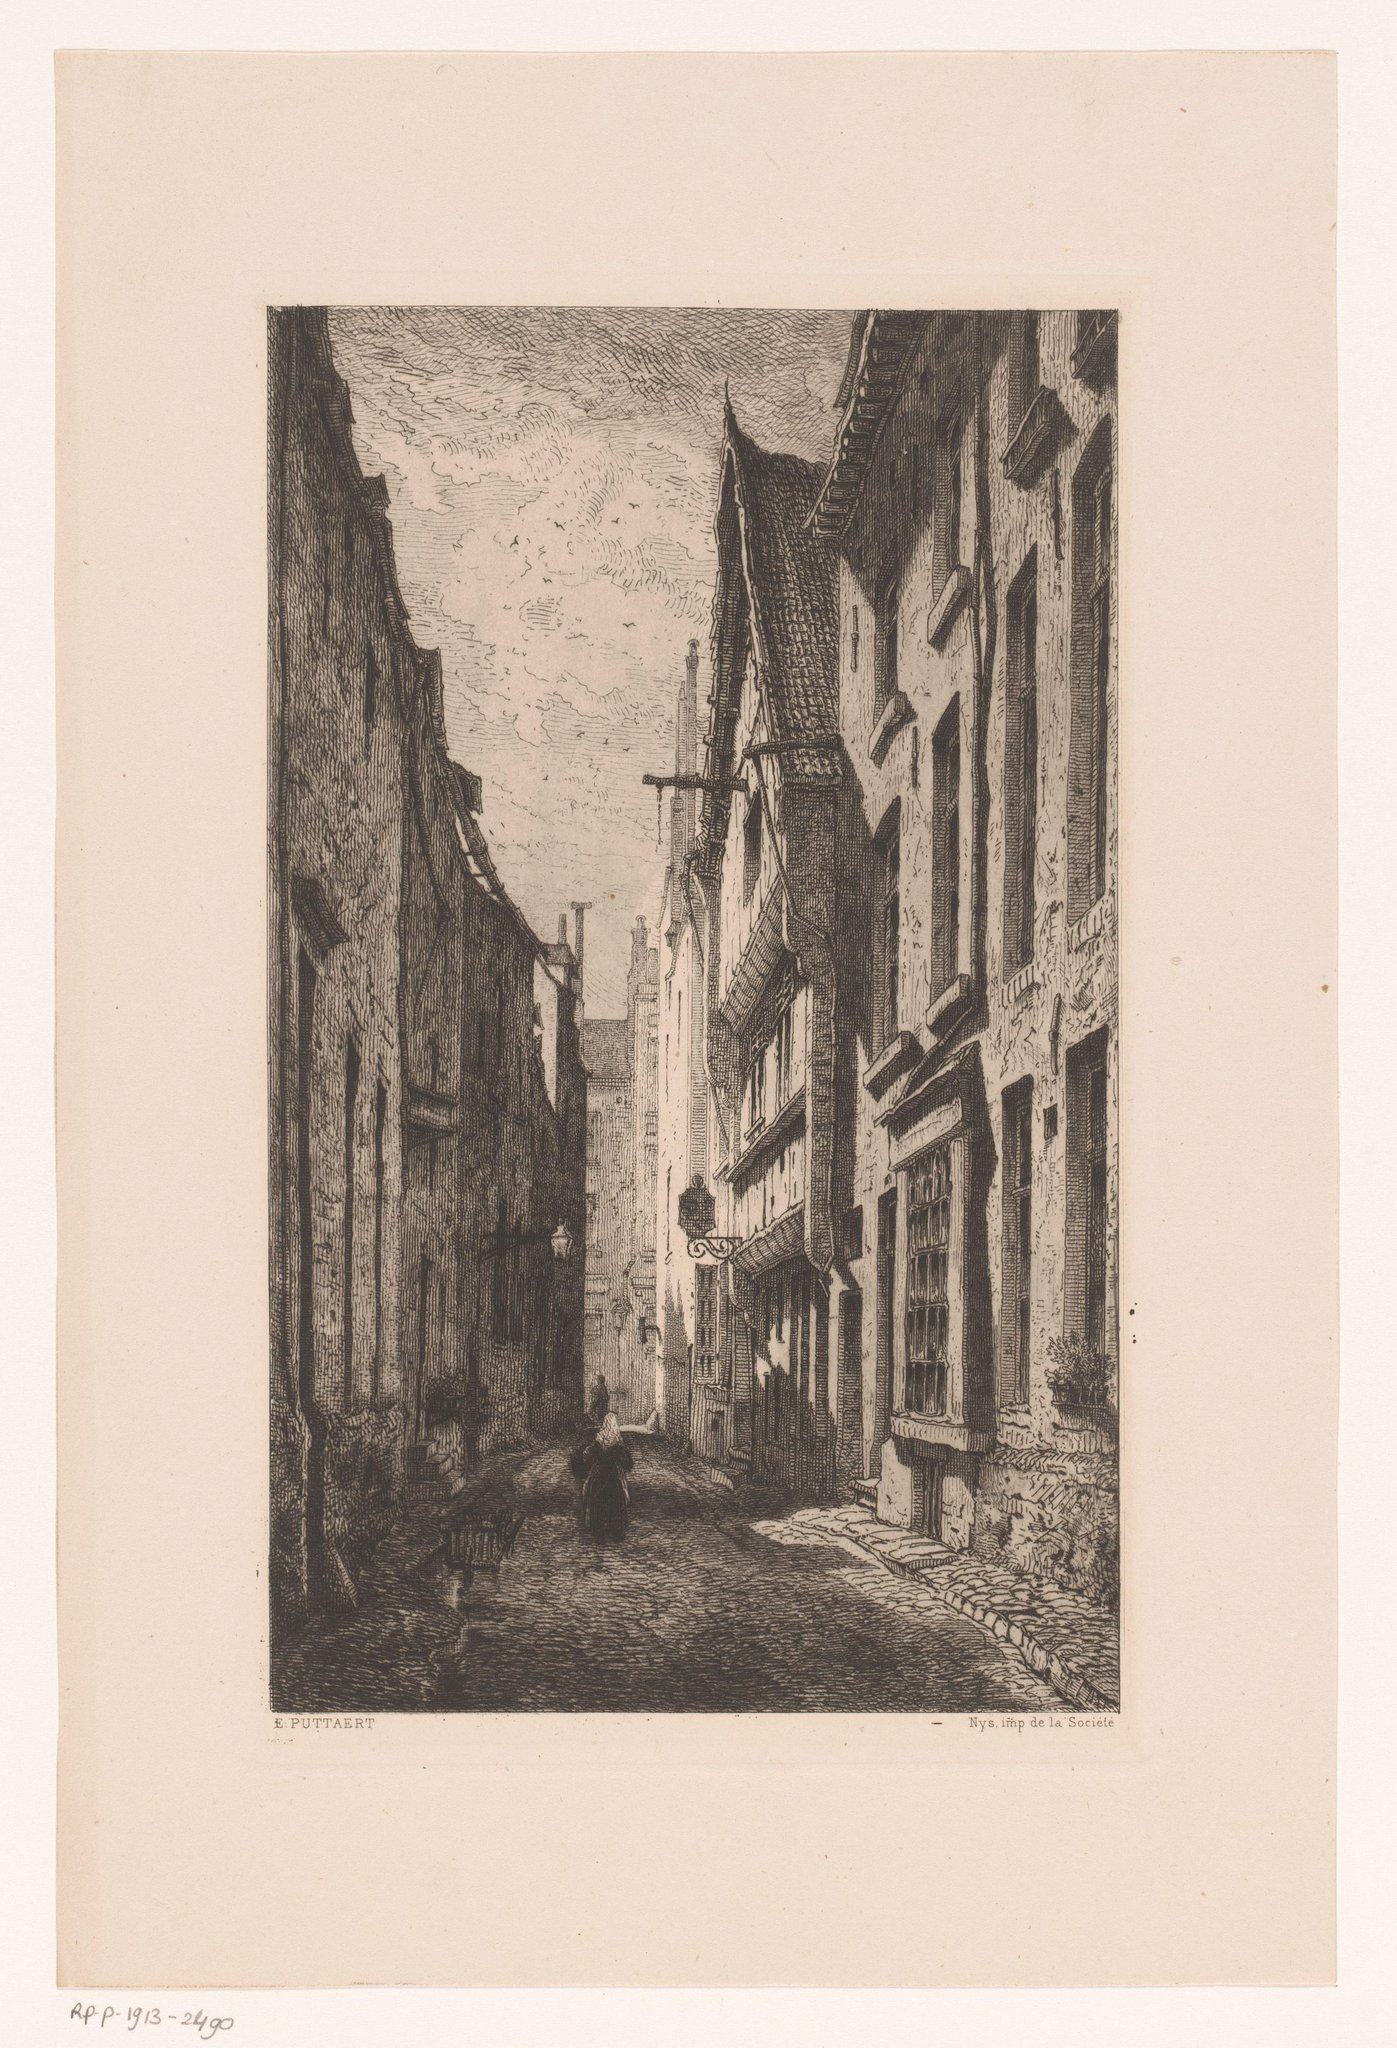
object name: print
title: Gezicht op een straat in Brussel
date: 1875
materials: paper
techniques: drypoint, etching, intaglio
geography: brussels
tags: street (+ city(-scape) with figures, staffage), brussels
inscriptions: collector's mark: Lugt 2228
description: Prent uit: Rops, Félicien (red.). Cahier d'études: eaux-fortes originales et inédites. Brussel: Felix Callewaert père, 1875. In deze publicatie verschenen onder de titel 'Petite rue des Pierres (Vieux-Bruxelles)'.